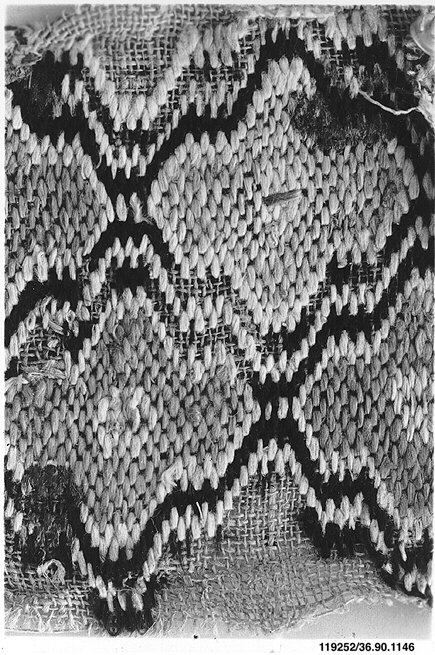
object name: piece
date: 1701-1800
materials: cotton, silk